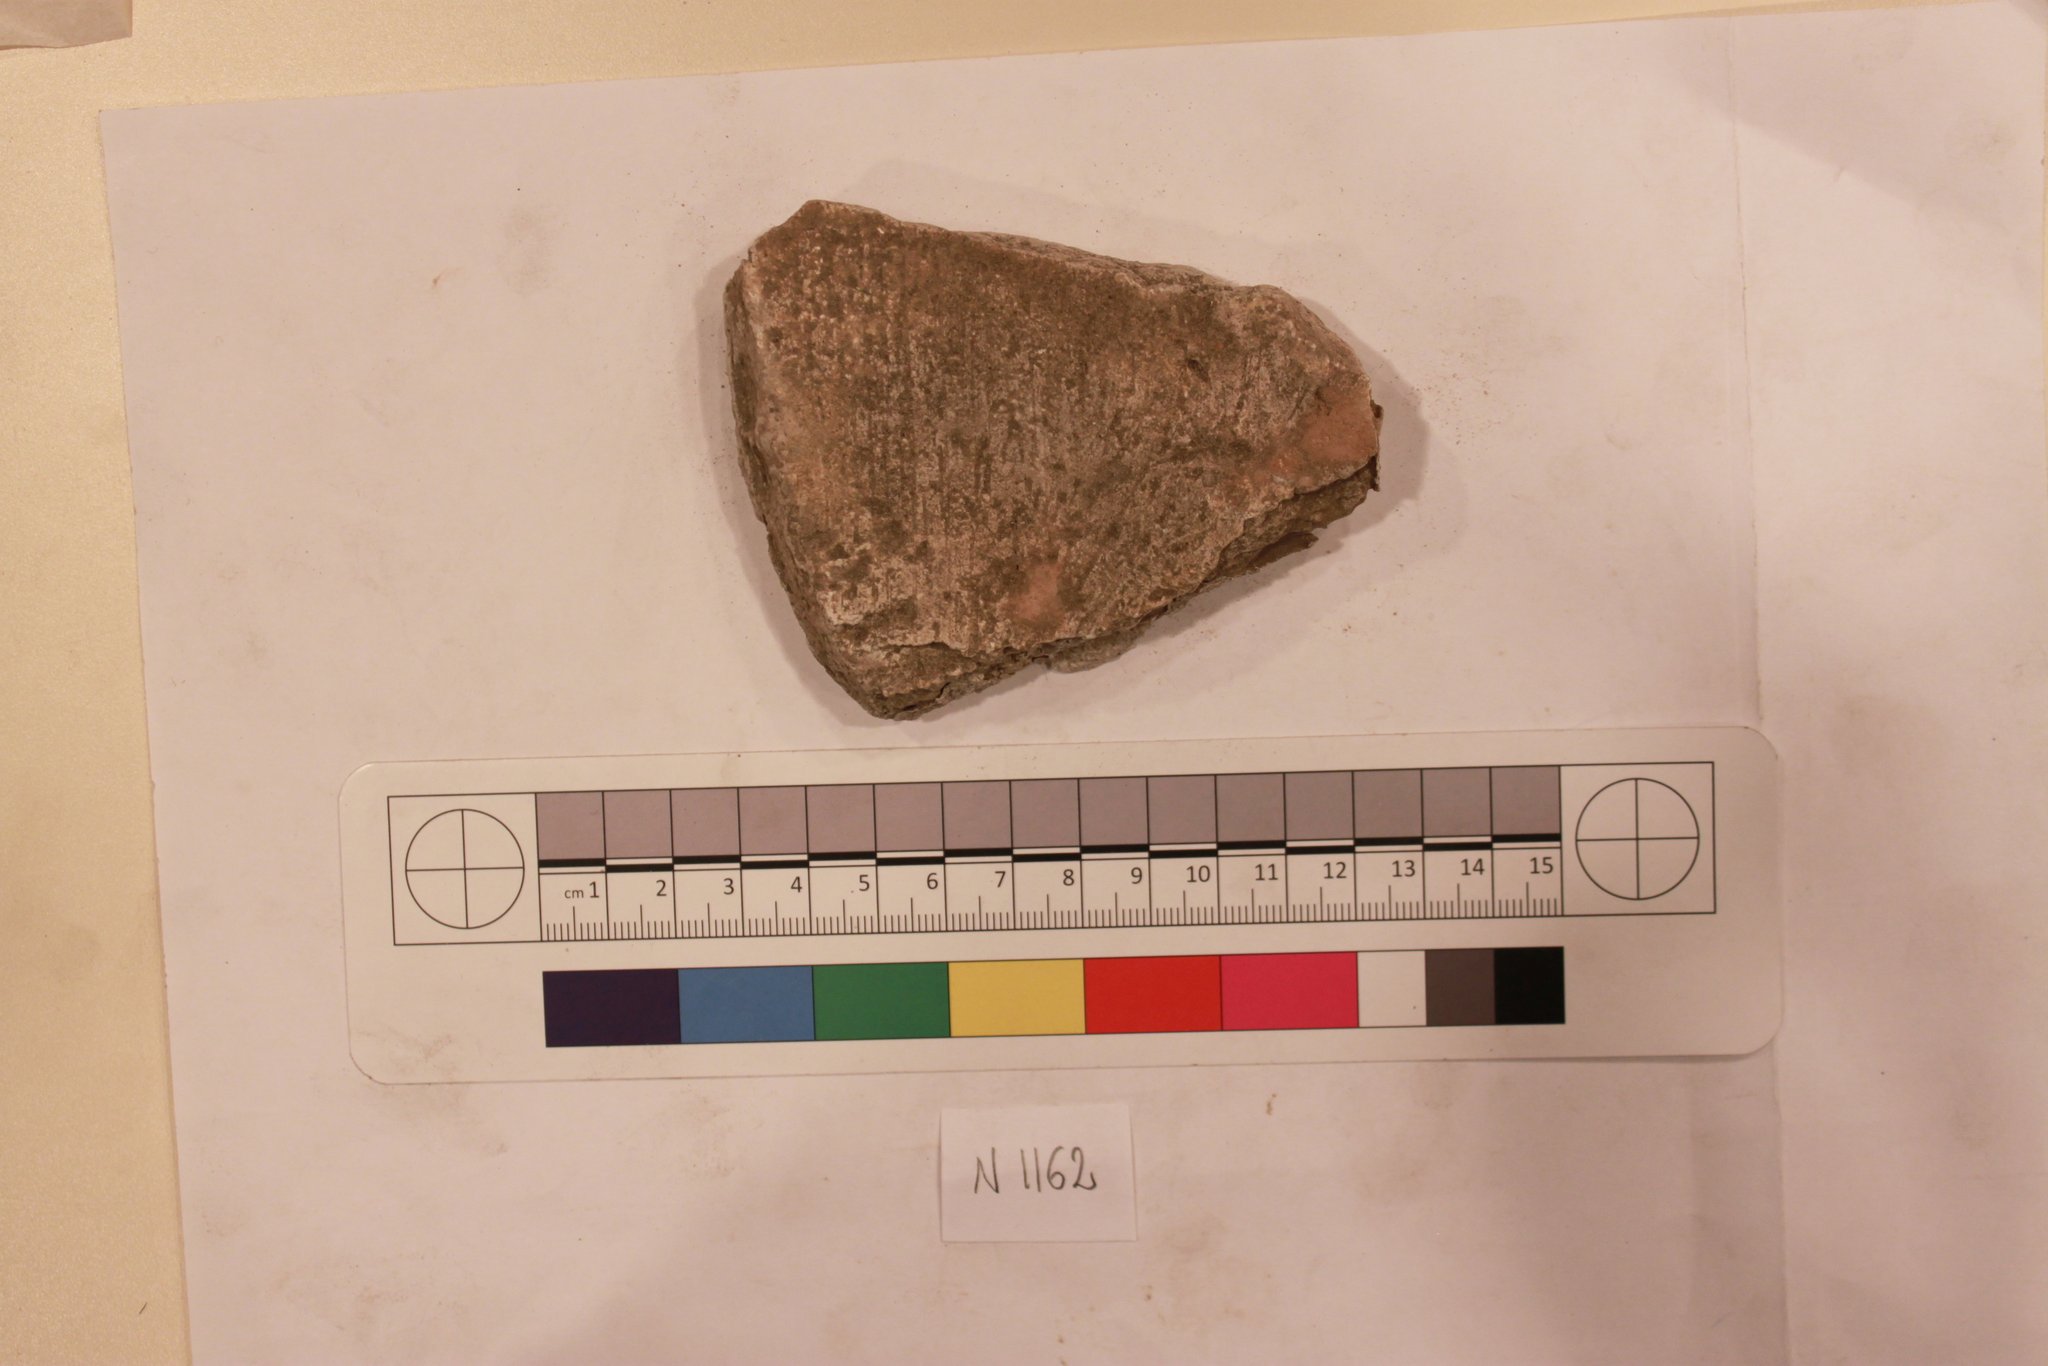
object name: fragment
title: Stucco Fragment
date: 701-1200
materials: plaster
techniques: carving, painting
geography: iran